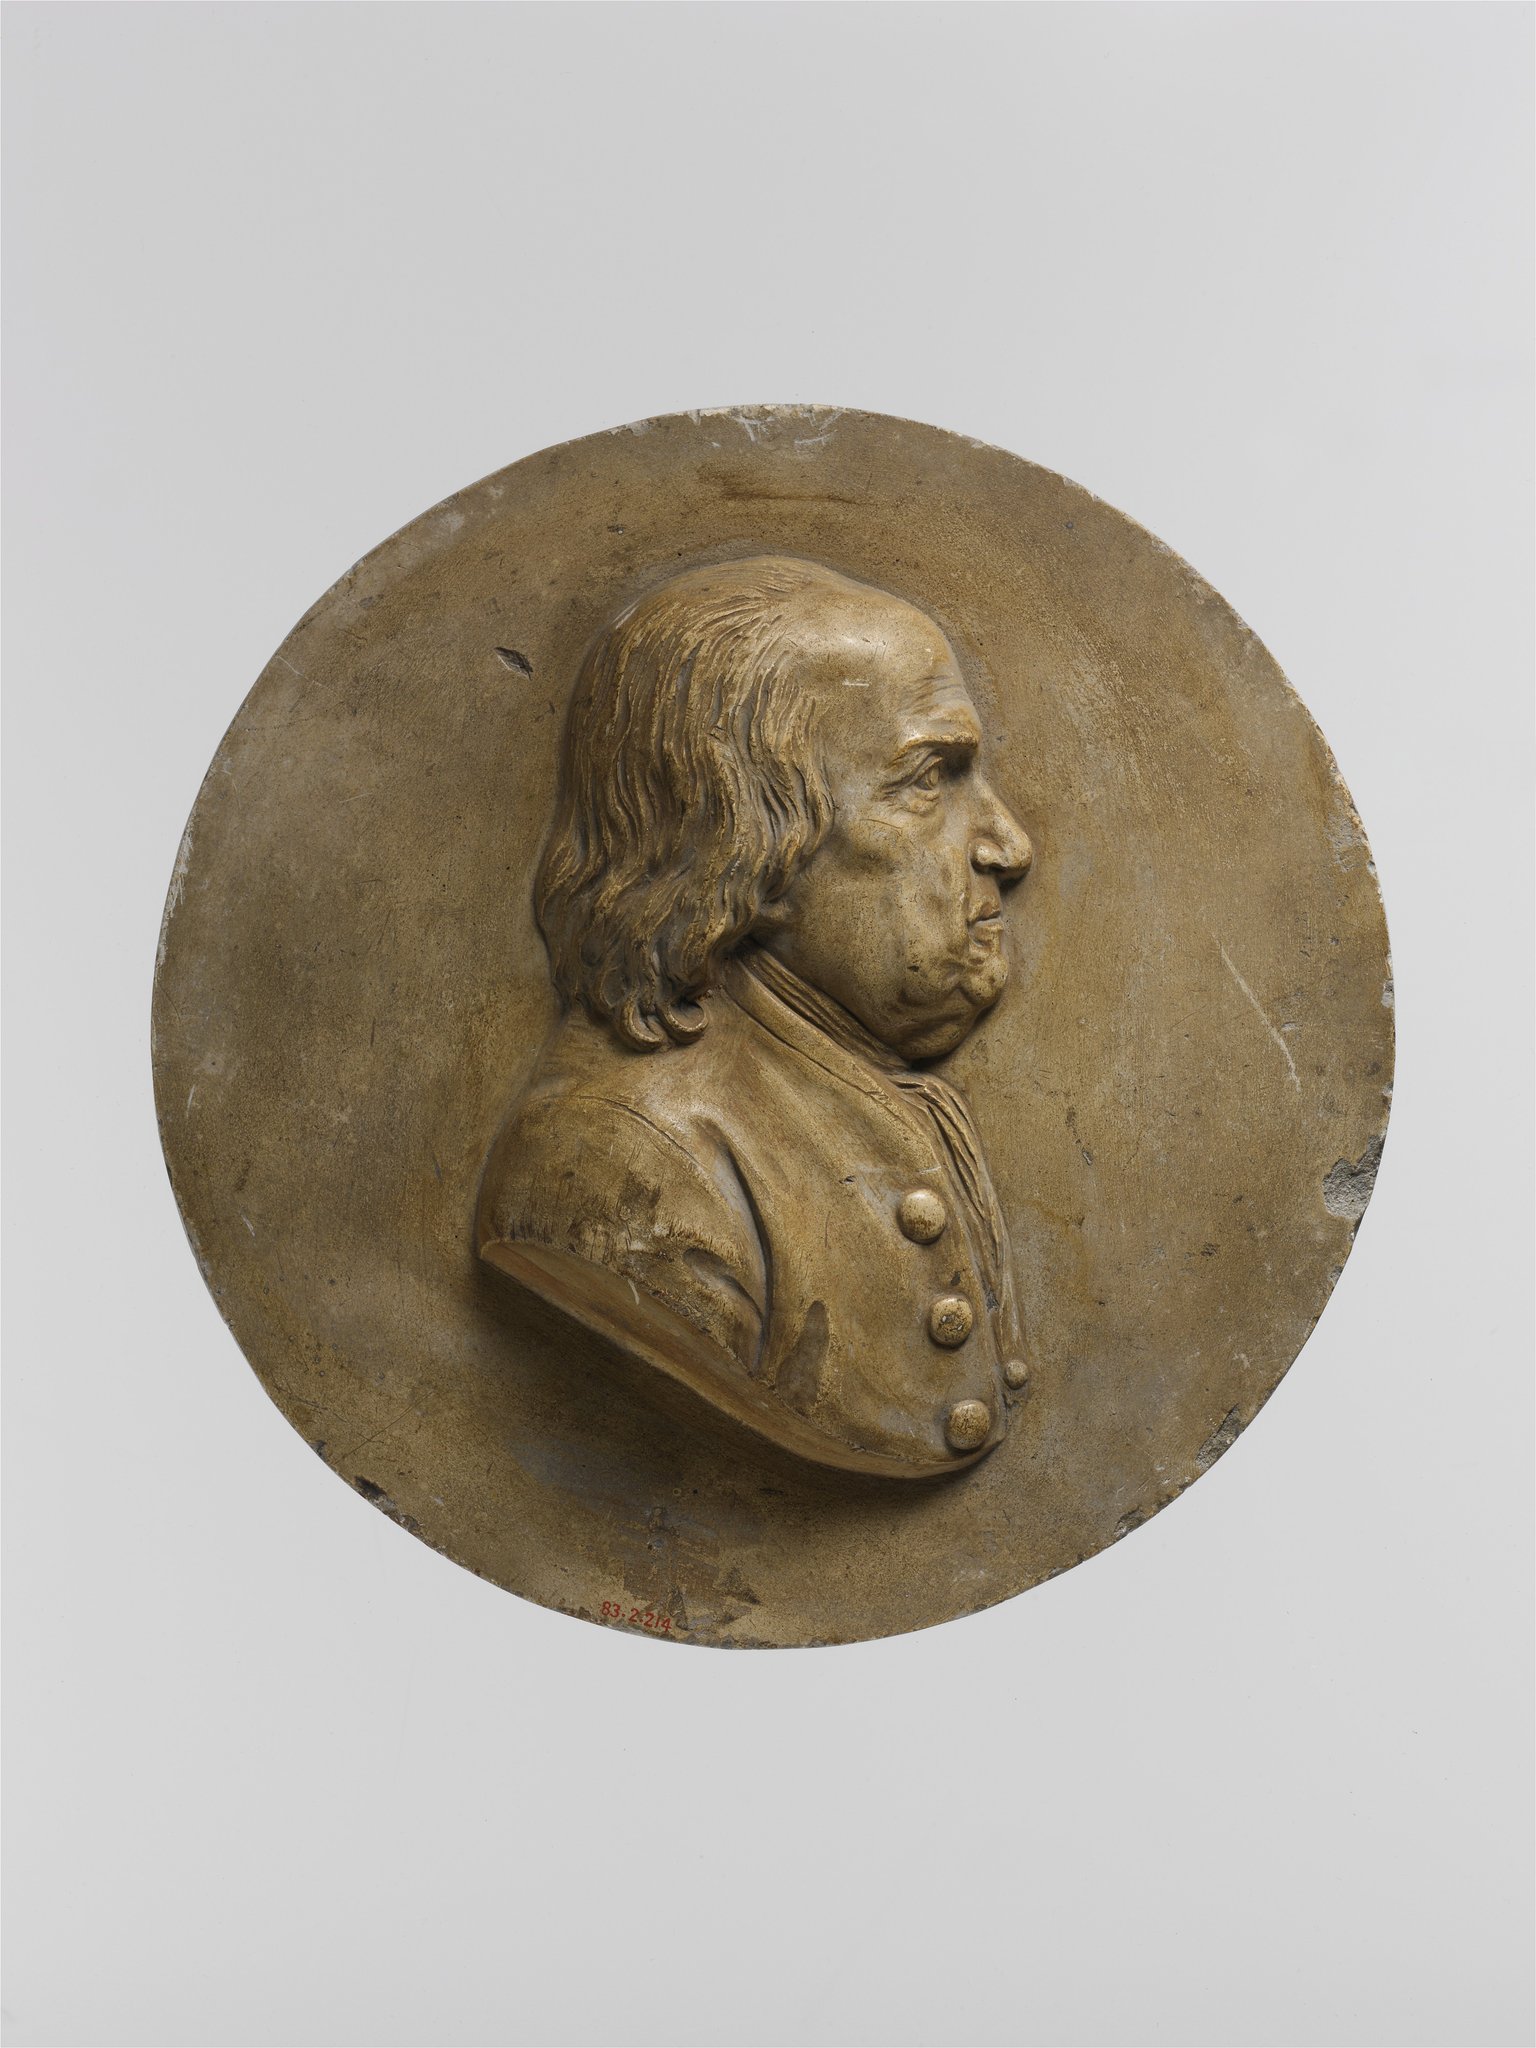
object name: medallion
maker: jean martin renaud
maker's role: maker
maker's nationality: french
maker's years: 1746-1821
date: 1776-1883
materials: plaster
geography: france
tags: benjamin franklin,men,profiles